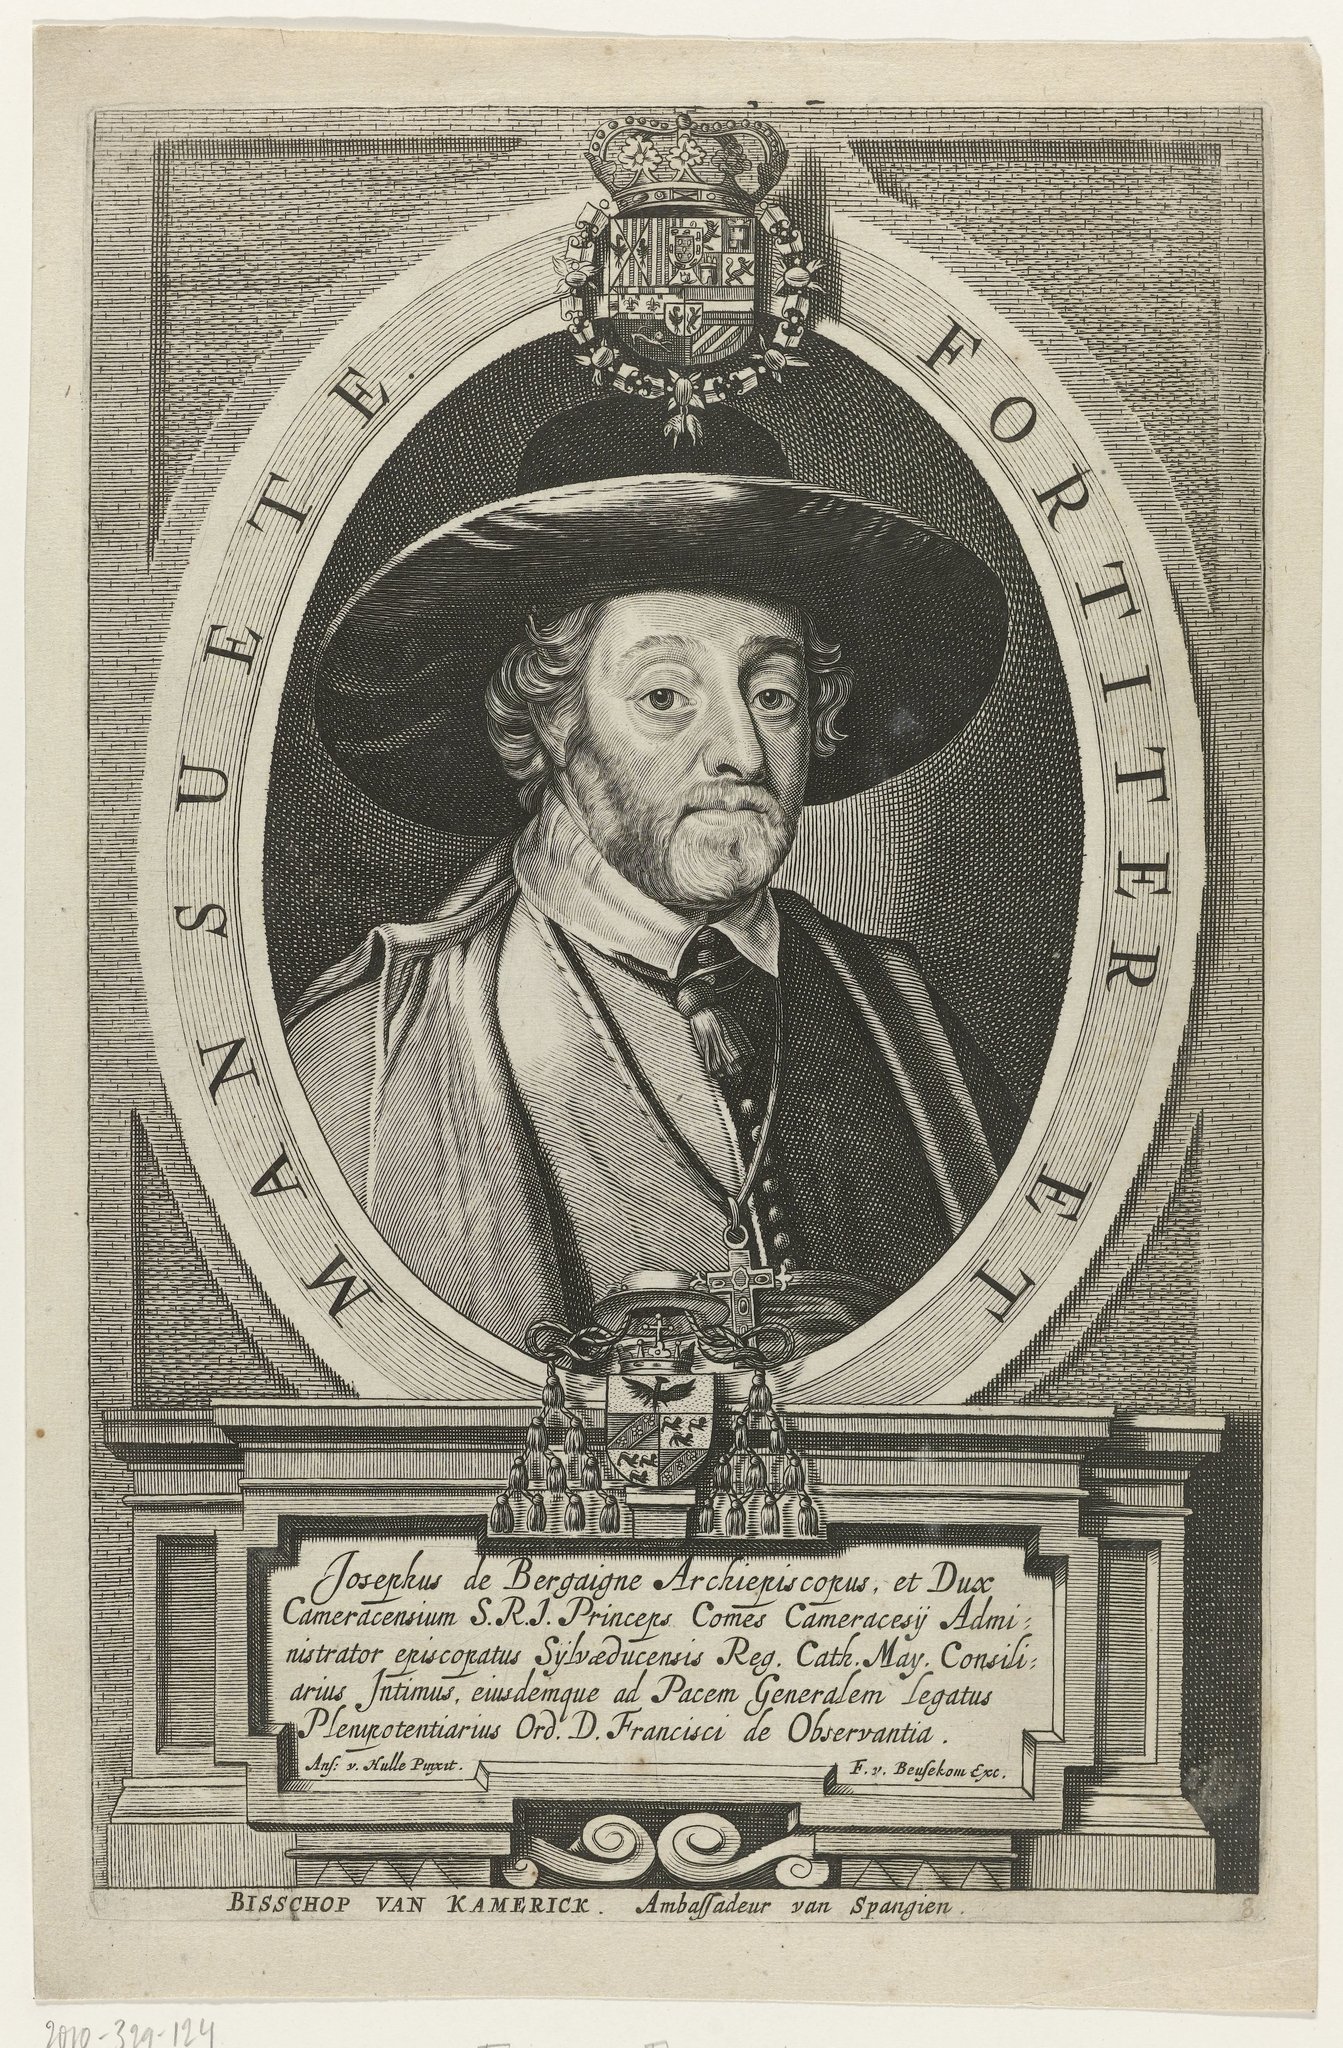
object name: print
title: Portret Josephus de Bergaigne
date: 1625-1675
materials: paper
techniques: engraving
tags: bisschop, aartsbisschop, joseph de bergaigne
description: Josephus de Bergaigne, bisschop van 's-Hertogenbosch, aartsbisschop van Kamerik, Spaans ambassadeur in 1647. Buste naar rechts, hoed met brede rand op het hoofd, in ovale lijst met randschrift en wapen middenboven. Onderaan cartouche met informatie over de Bergaigne in het Latijn.